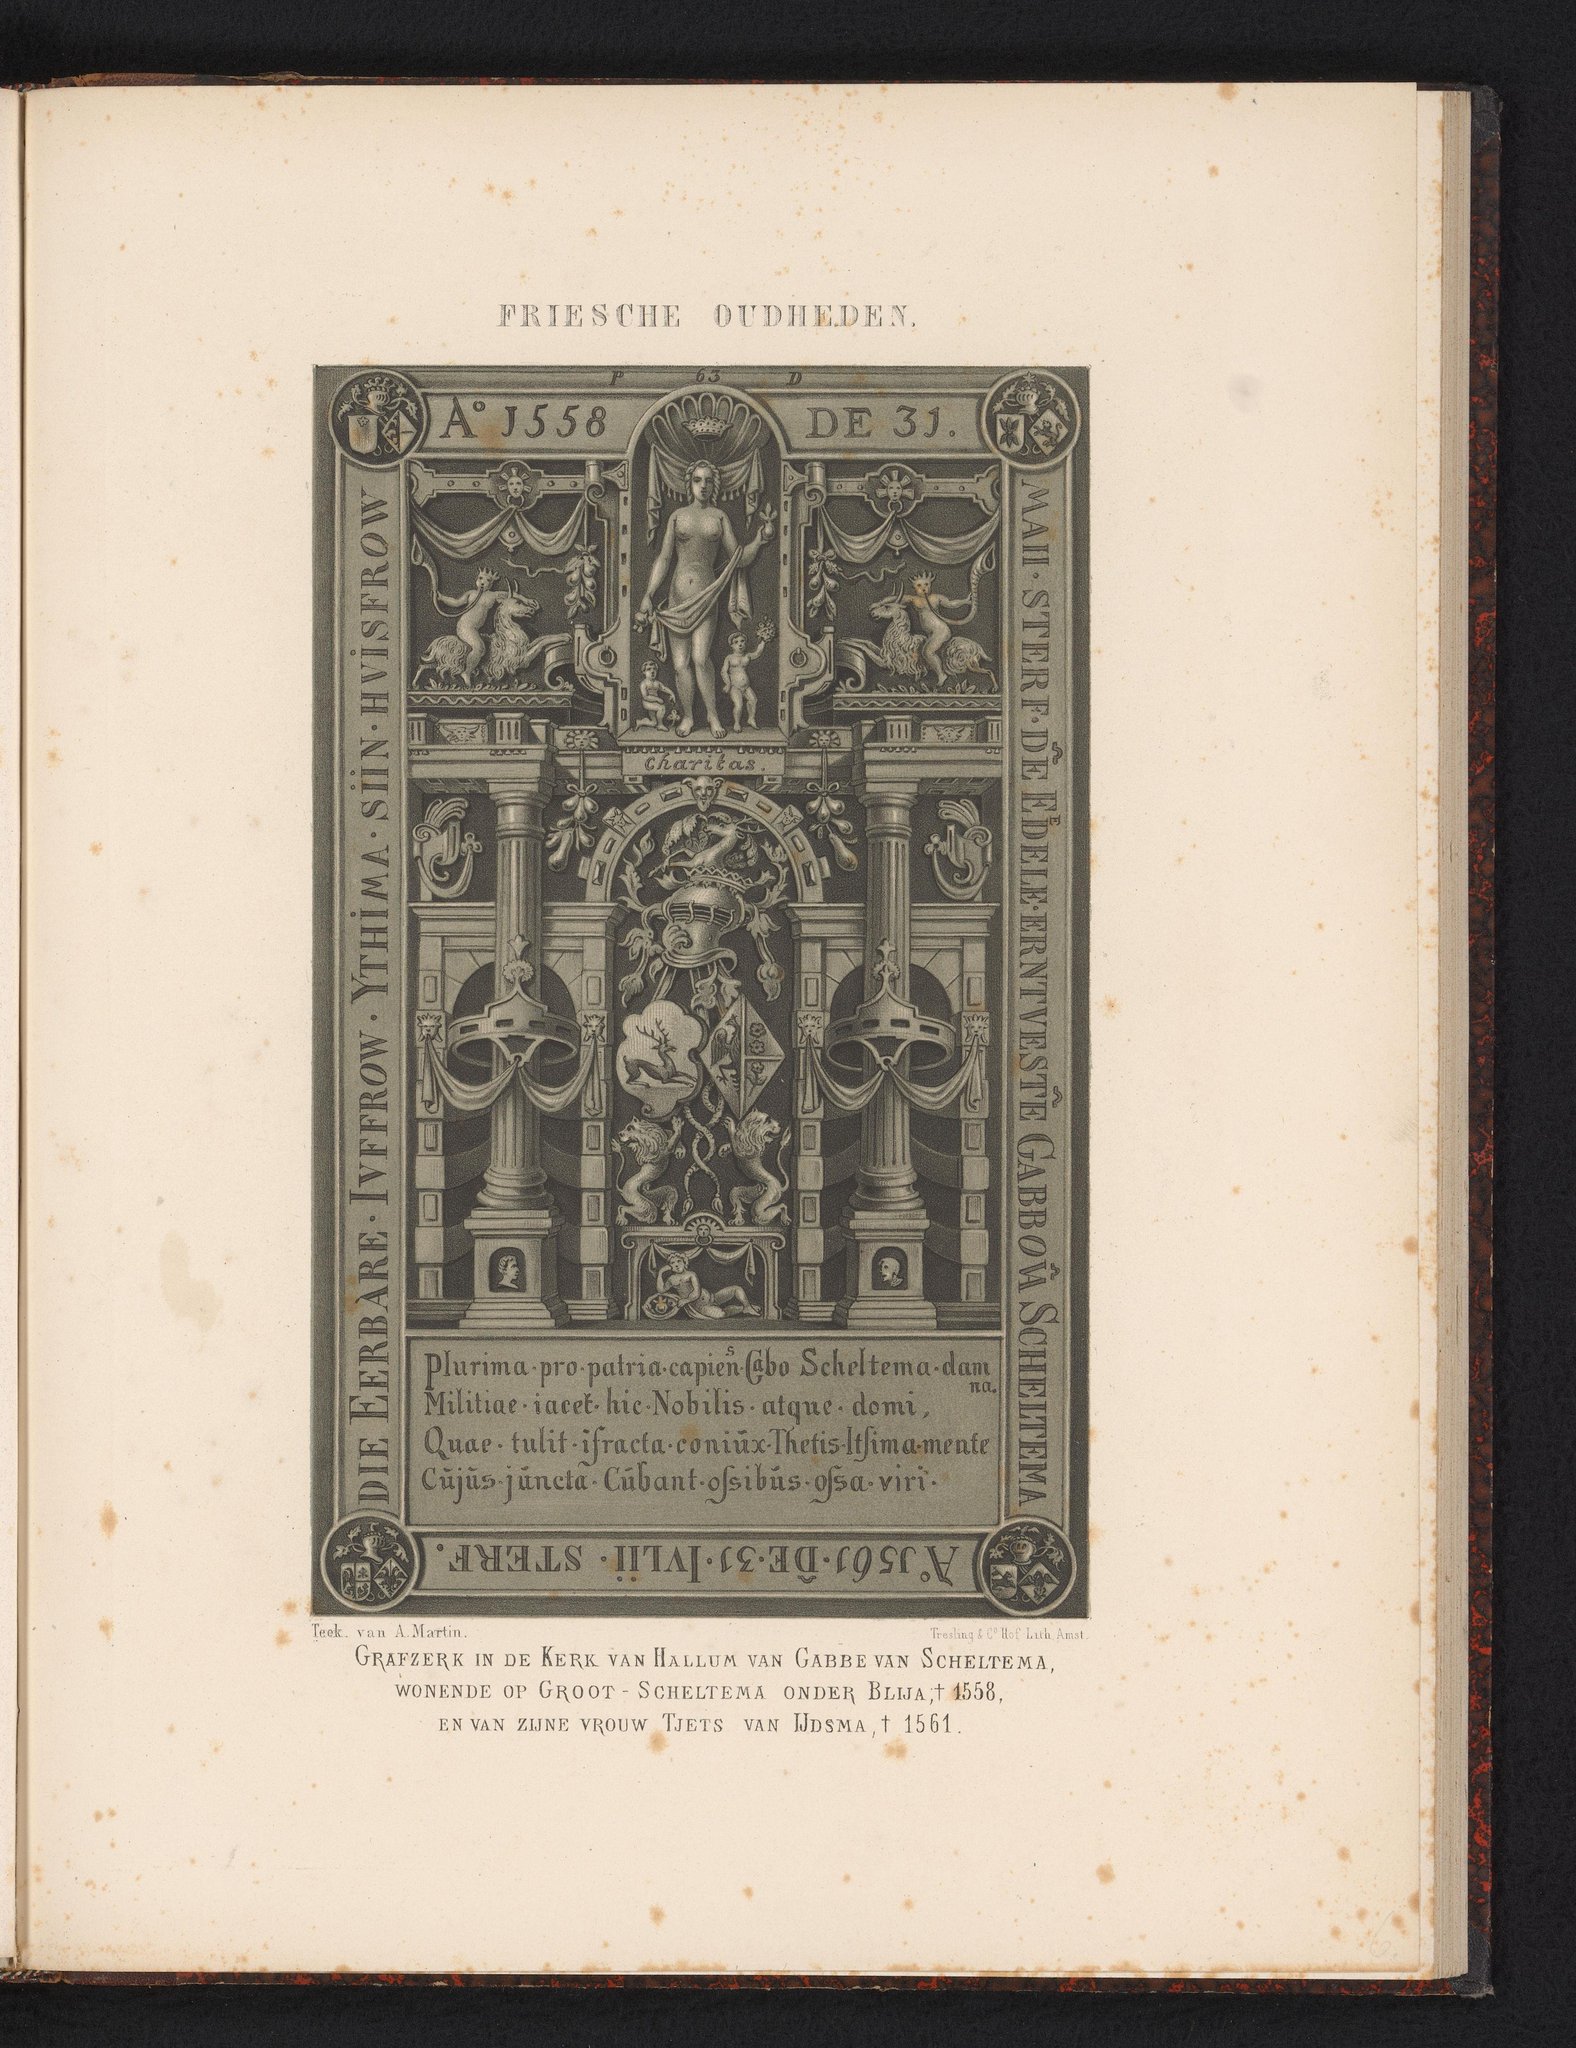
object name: print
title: Grafzerk in de Kerk van Hallum van Gabbe van Scheltema, wonende op Groot-Scheltema onder Blija, [gestorven] 1558, en van zijne vrouw Tjets van IJdsma, [gestorven] 1561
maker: albert martin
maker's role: draughtsman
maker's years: 1827-1900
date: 1870-1875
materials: paper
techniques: lithograph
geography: amsterdam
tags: grave, tomb and other grave-forms and grave-markers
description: Illustratie in: Friesche Oudheden. Afbeeldingen van merkwaardige voorwerpen van Wetenschap en Kunst, gevonden in de archieven, kerken, kasteelen, terpen enz. van Friesland, Leeuwarden 1875. Niet in Frederik Muller; door het RPK toegevoegd nummer.